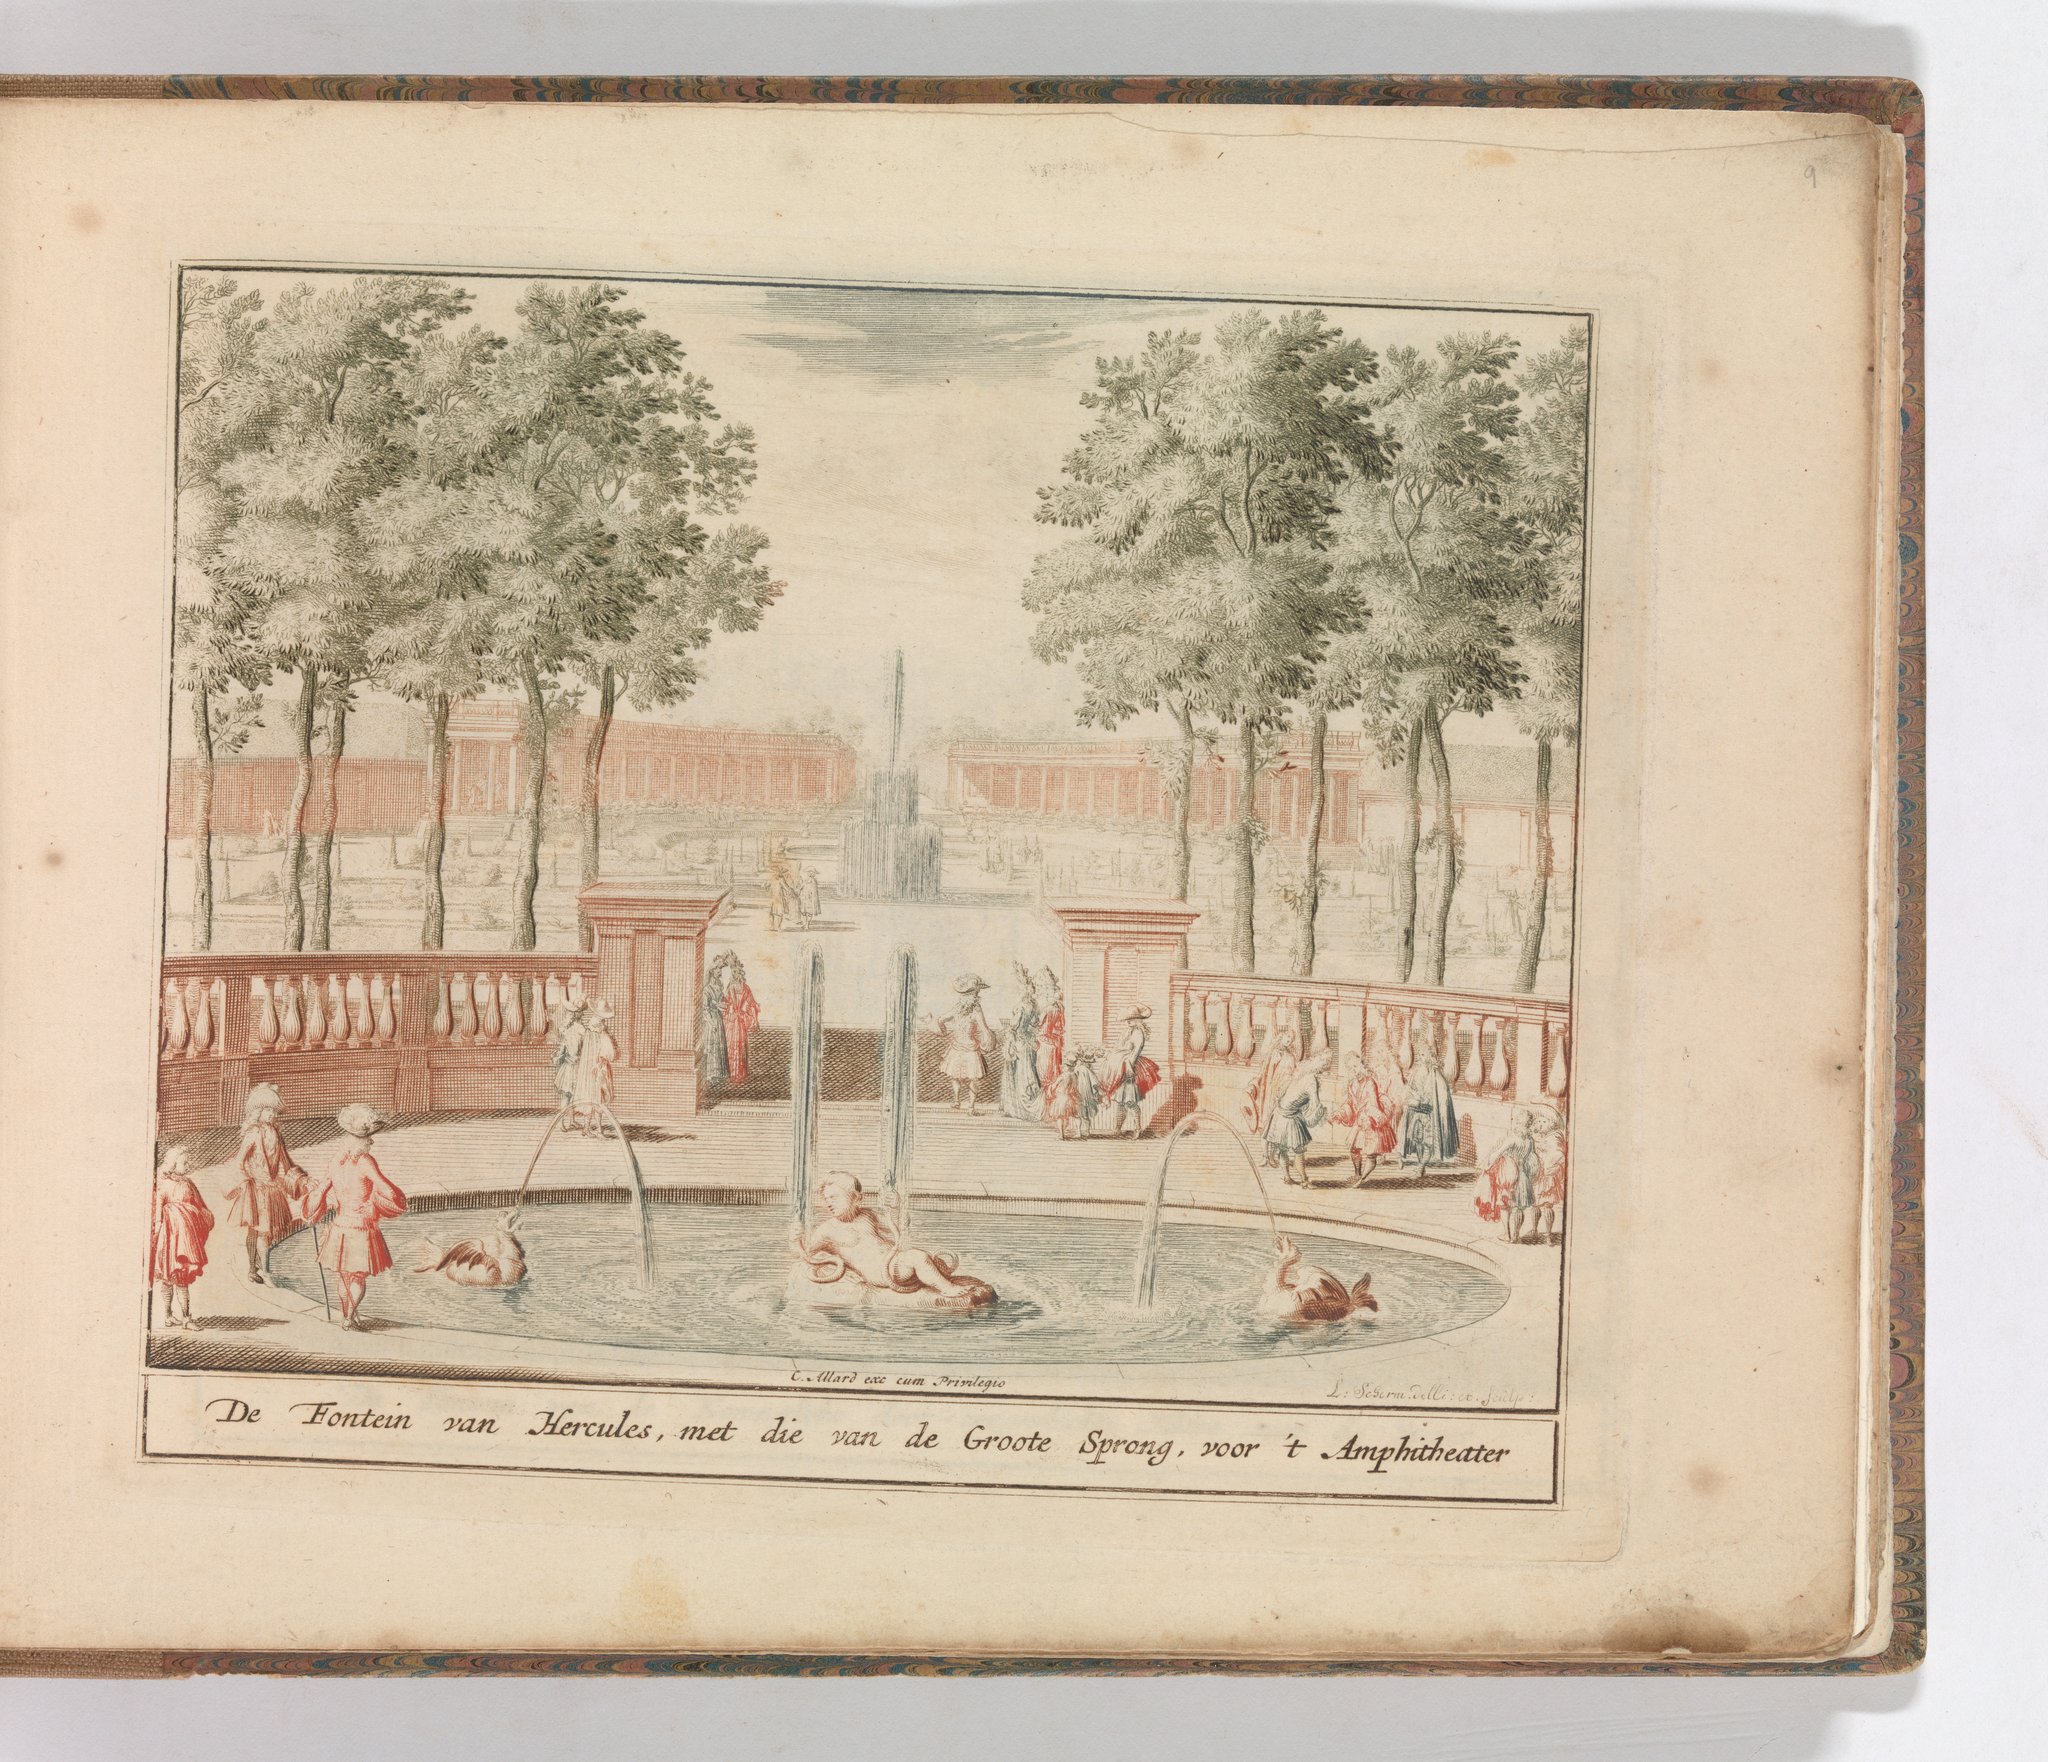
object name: book print ornament architecture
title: 'De Fontein van Hercules, met die van de Groote Sprong, voor 't Amphitheater', in: Tooneel Der Voornaamste Nederlands Huizen, En Lust Hoven, Naar T Leven Afgebeeld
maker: carel allard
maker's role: publisher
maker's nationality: dutch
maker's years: 1648-1709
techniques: engraving, lithography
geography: amsterdam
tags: fountains,gardens,men,women